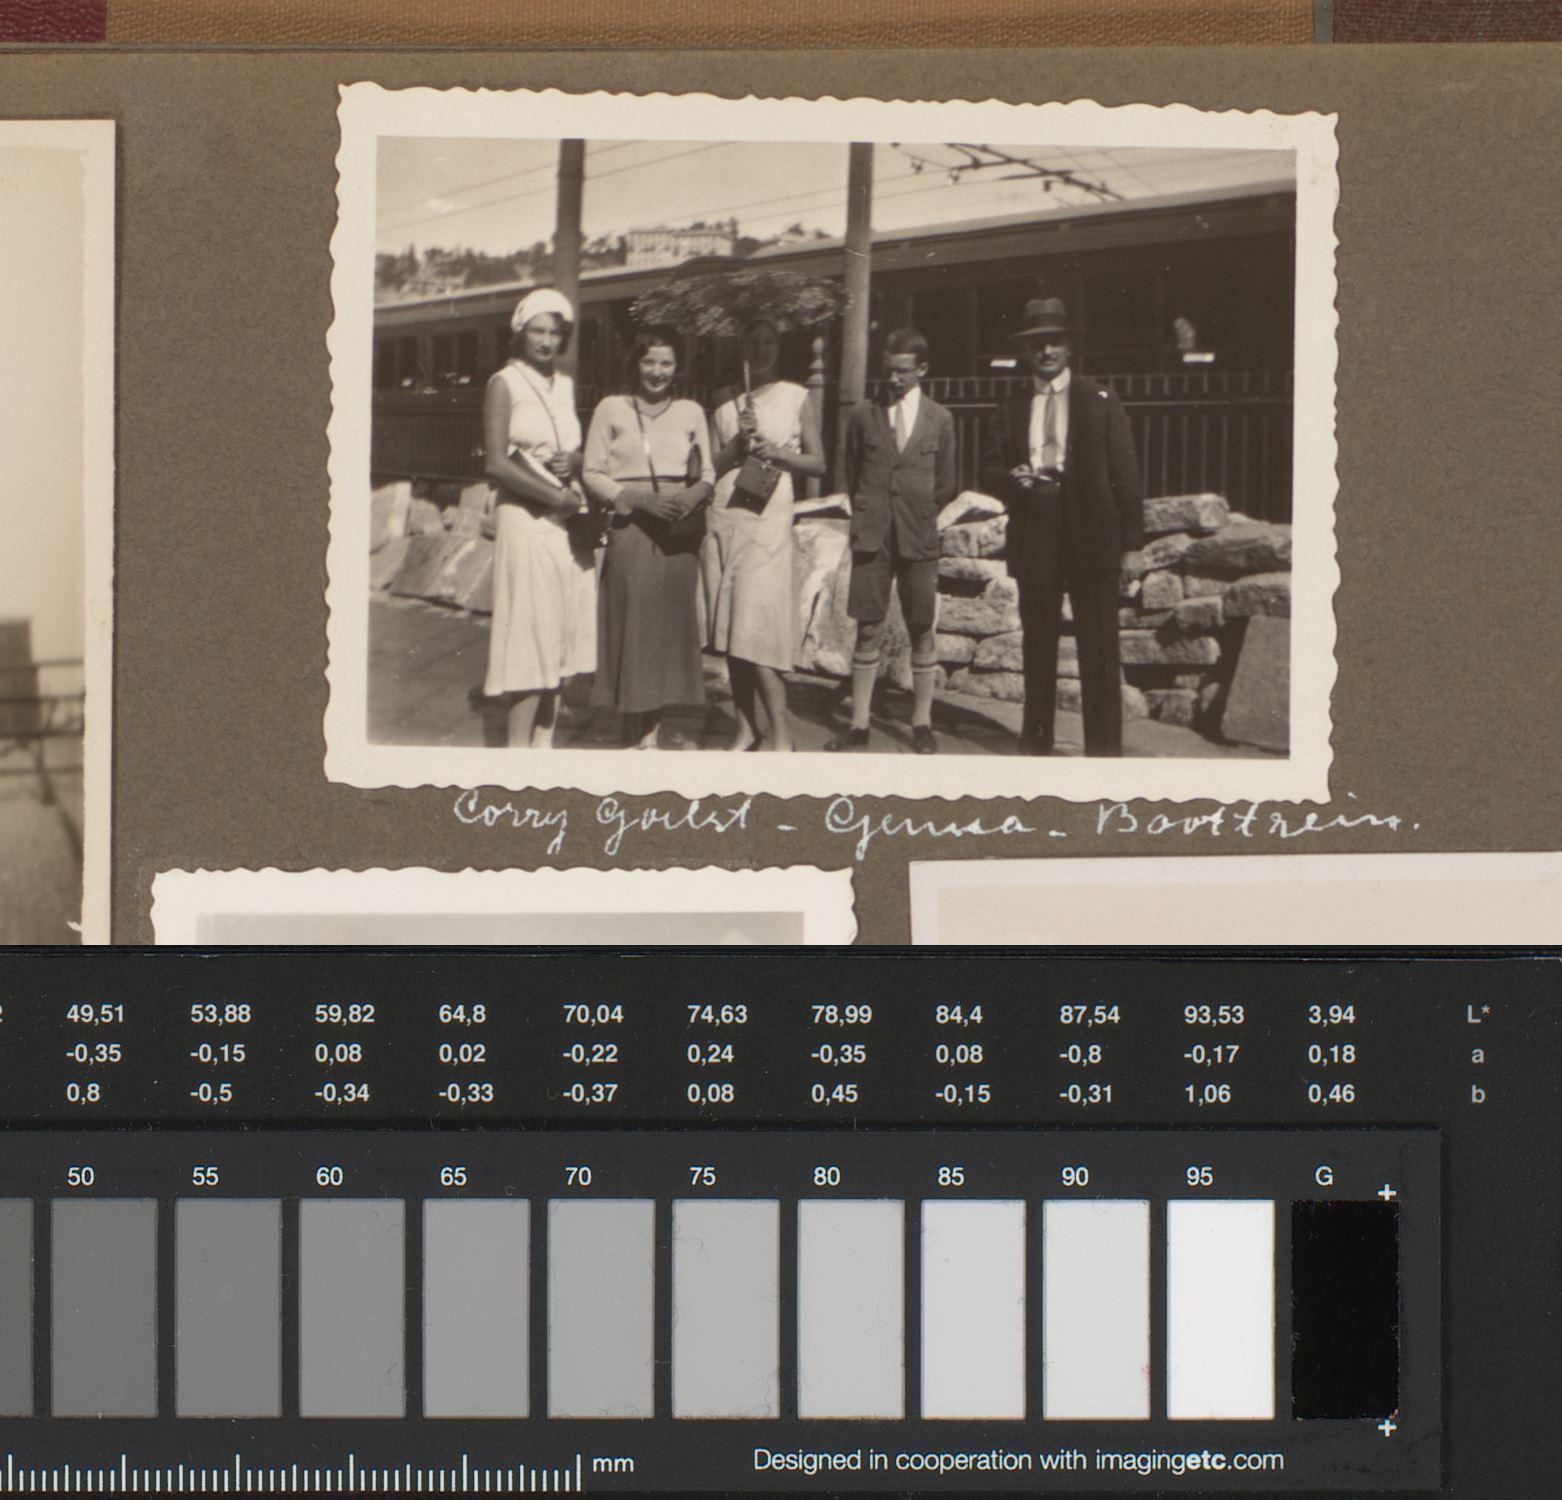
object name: album leaf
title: Groepsportret bij een trein in Genua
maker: Anonymous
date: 1932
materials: paper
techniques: gelatin silver print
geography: genoa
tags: passenger train, historical persons - bb - woman, historical persons not known by name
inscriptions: inscription: ‘Corry Goelst - Genua - Boottrein’